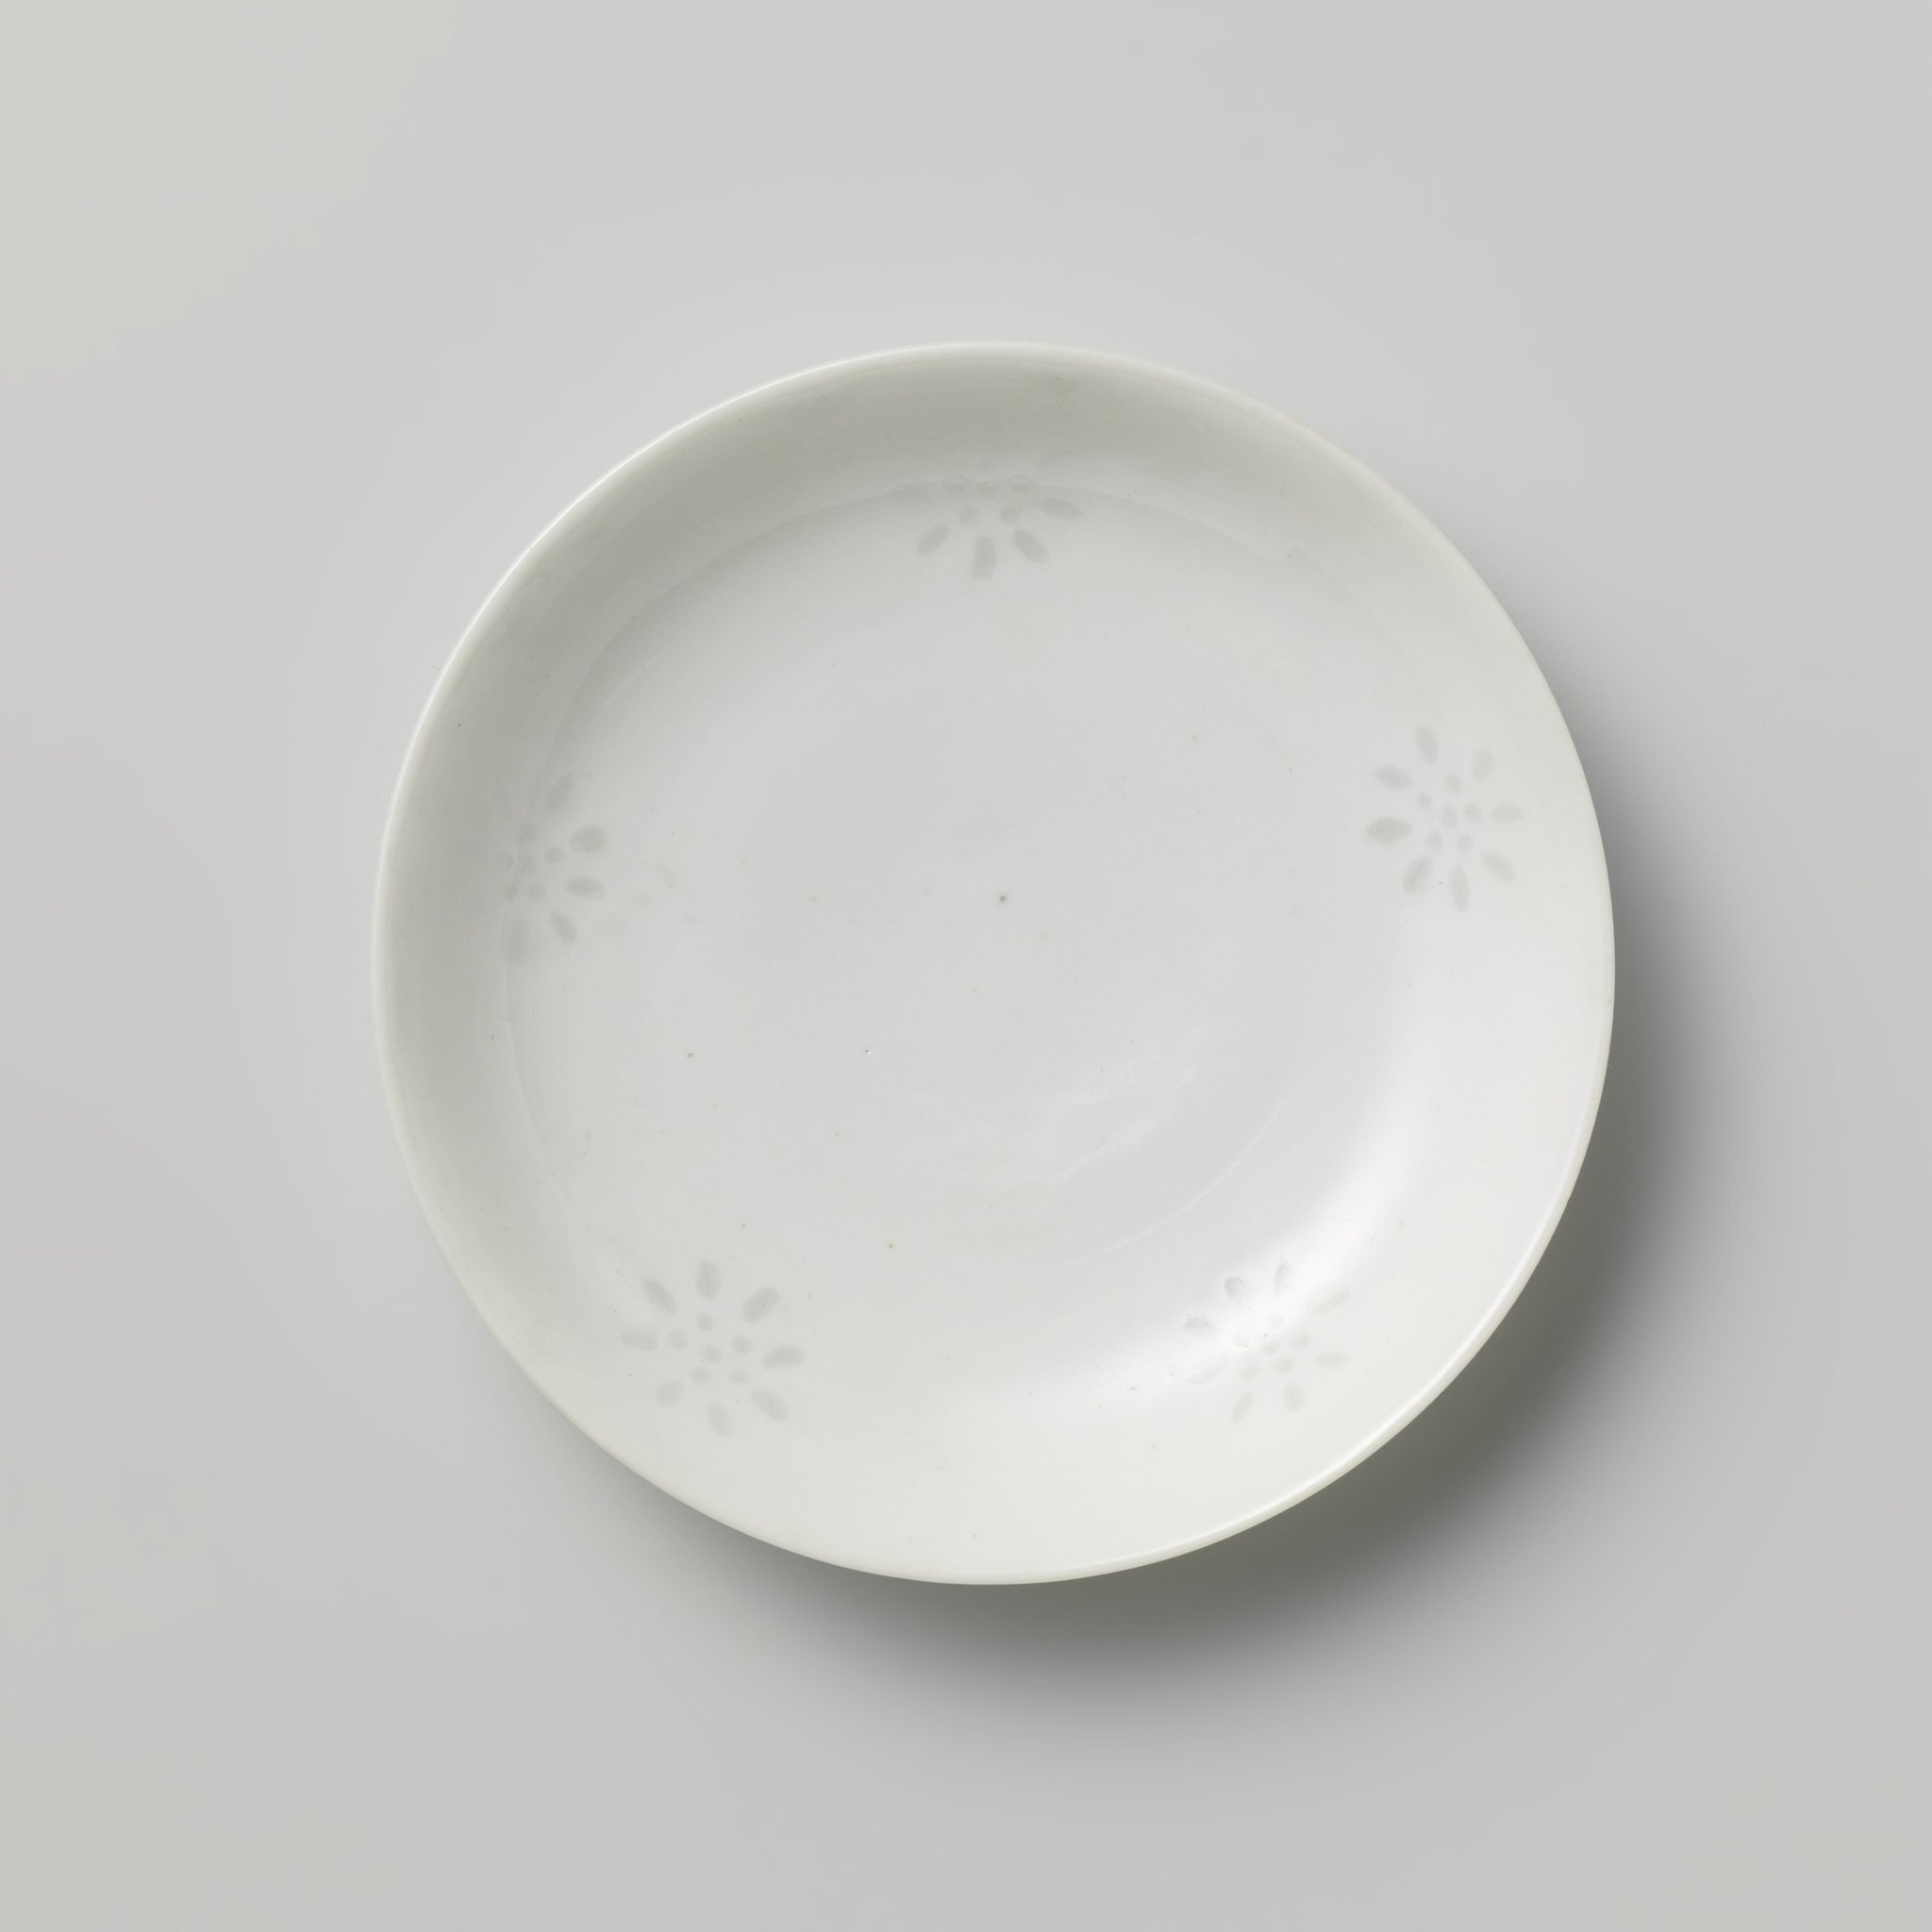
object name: platter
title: Saucer with translucents rice-grain roundels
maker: Anonymous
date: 1700-1724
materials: glaze, porcelain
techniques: embroidery, firing, turning, vitrification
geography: china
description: Schotel van porselein, bedekt met een doorschijnend wit glazuur. De wanden zijn opengewerkt (ajourwerk) in vijf rozetten van rijstwerk. Wit porselein, monochromen.